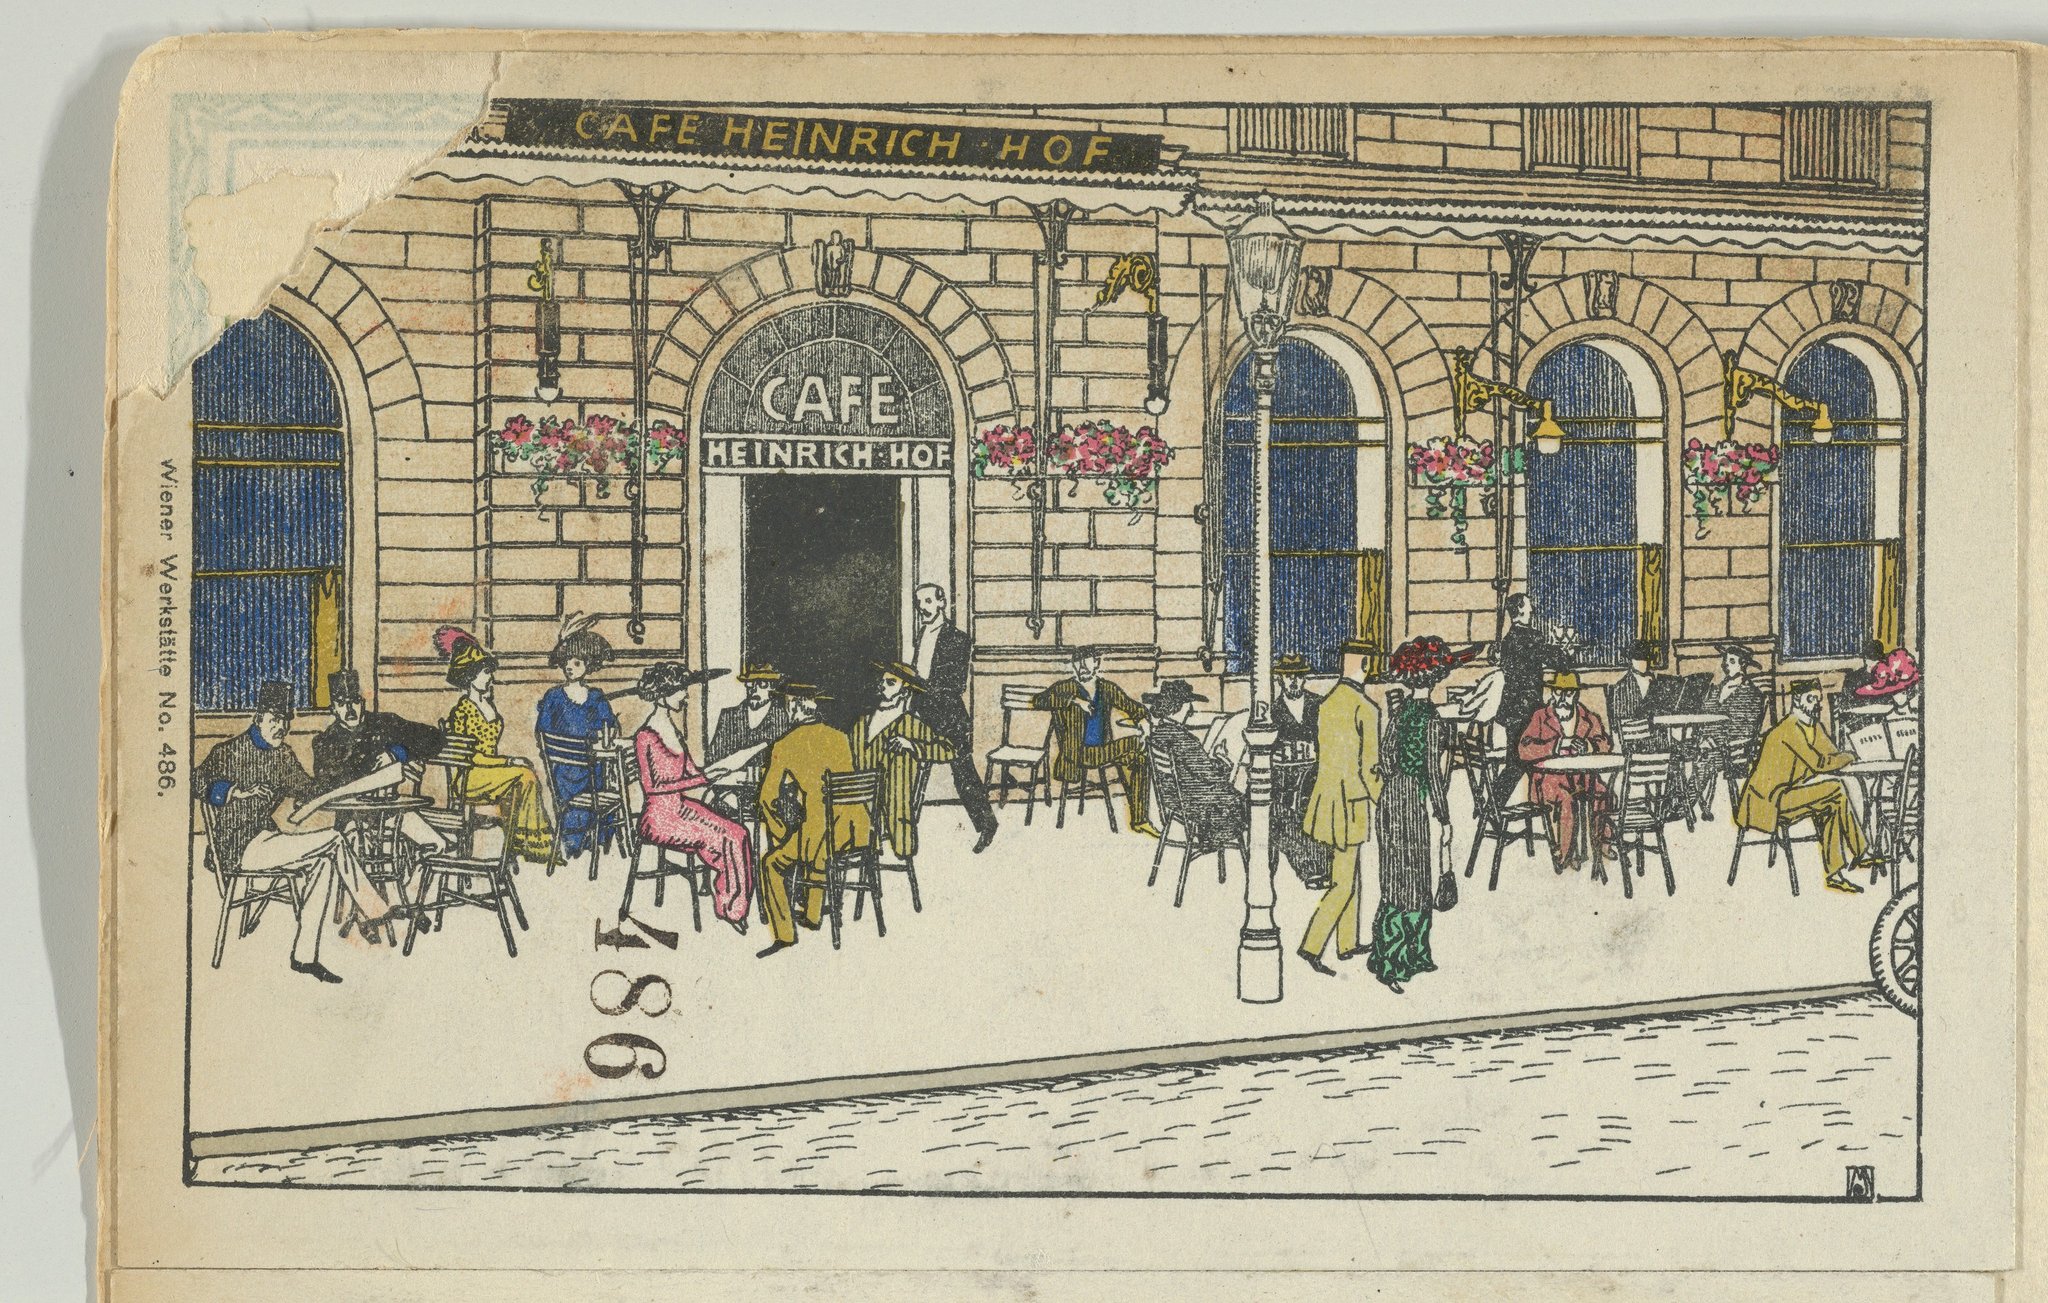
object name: print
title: Café Heinrichhof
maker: moriz jung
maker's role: artist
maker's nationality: austrian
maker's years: 1885-1915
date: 1912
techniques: lithograph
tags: restaurants,men,women